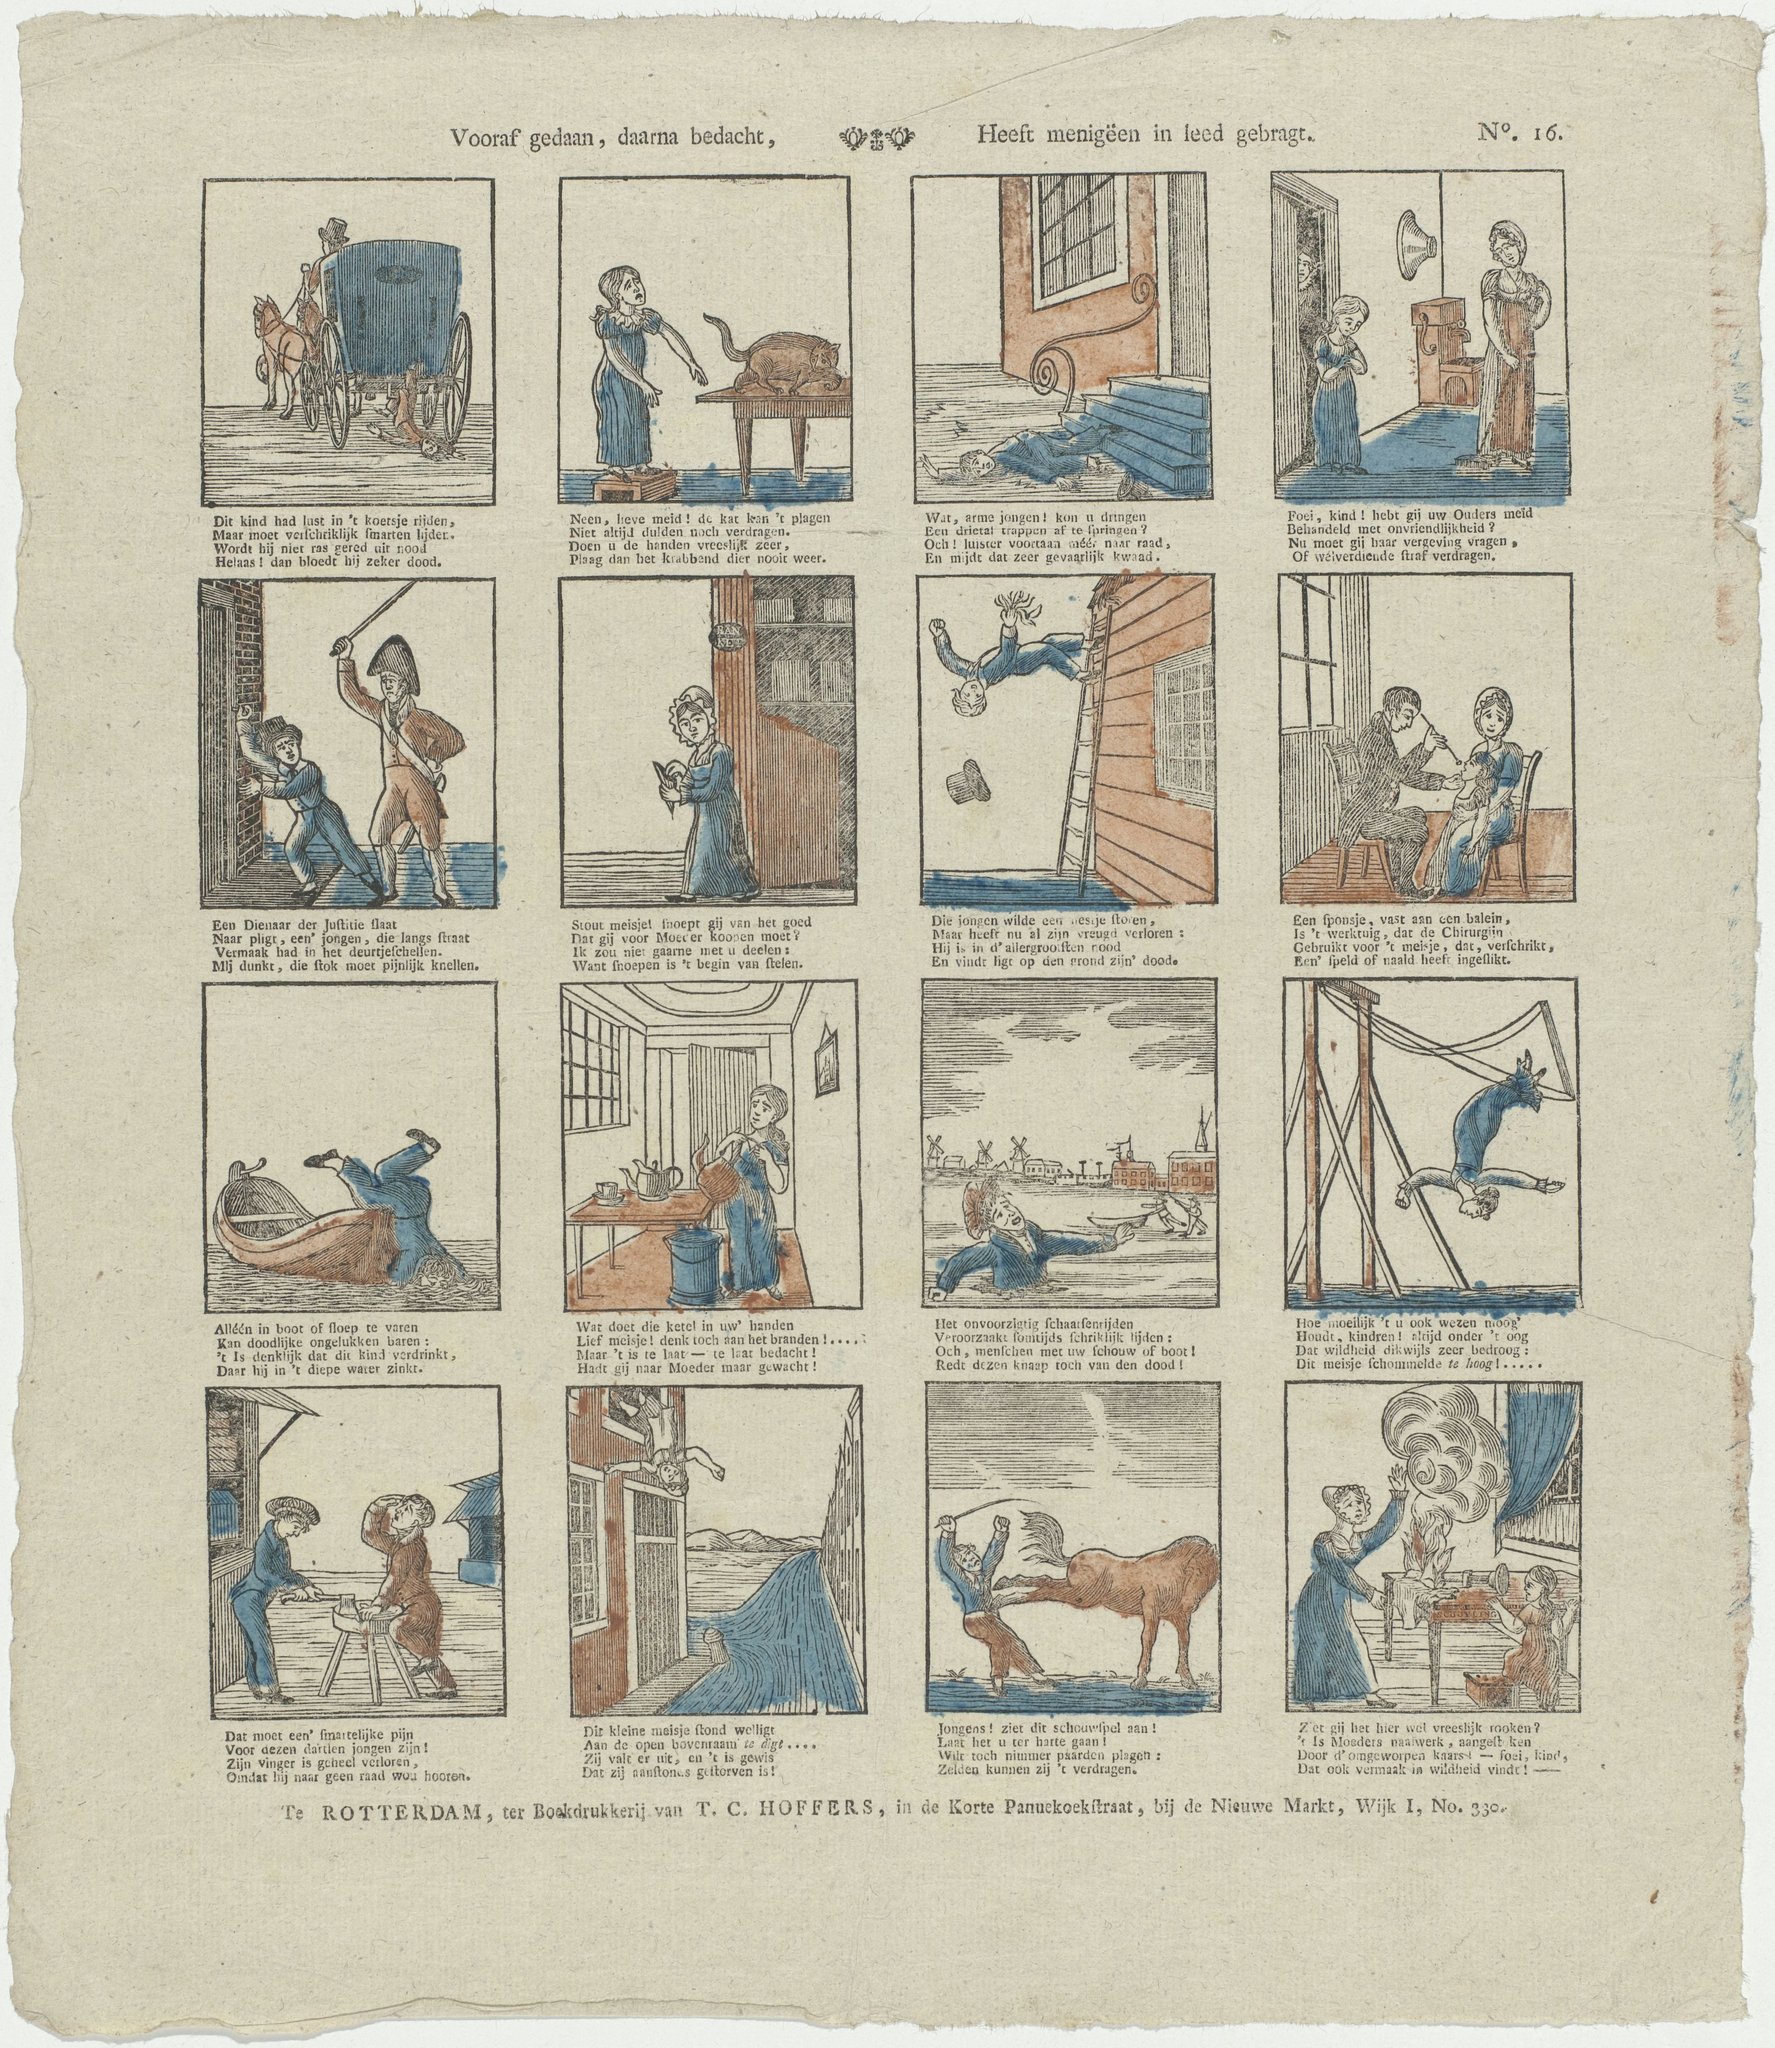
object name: popular print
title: Vooraf gedaan, daarna bedacht, / heeft menigëen in leed gebragt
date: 1820-1848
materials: paper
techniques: colour, letterpress printing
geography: rotterdam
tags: children's images (+ accident (in sports, games, etc.))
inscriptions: collector's mark: Lugt 2760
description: Blad met 16 voorstellingen van ondoordacht gedrag van kinderen, zoals een meisje dat een naald heeft doorgeslikt, een meisje dat uit een raam valt en een jongen die zijn vinger heeft afgehakt met een bijl. Onder elke afbeelding een vierregelig vers. Genummerd rechtsboven: No. 16.